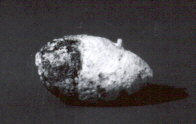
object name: ornament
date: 2333-2001 BCE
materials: faience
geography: mesopotamia